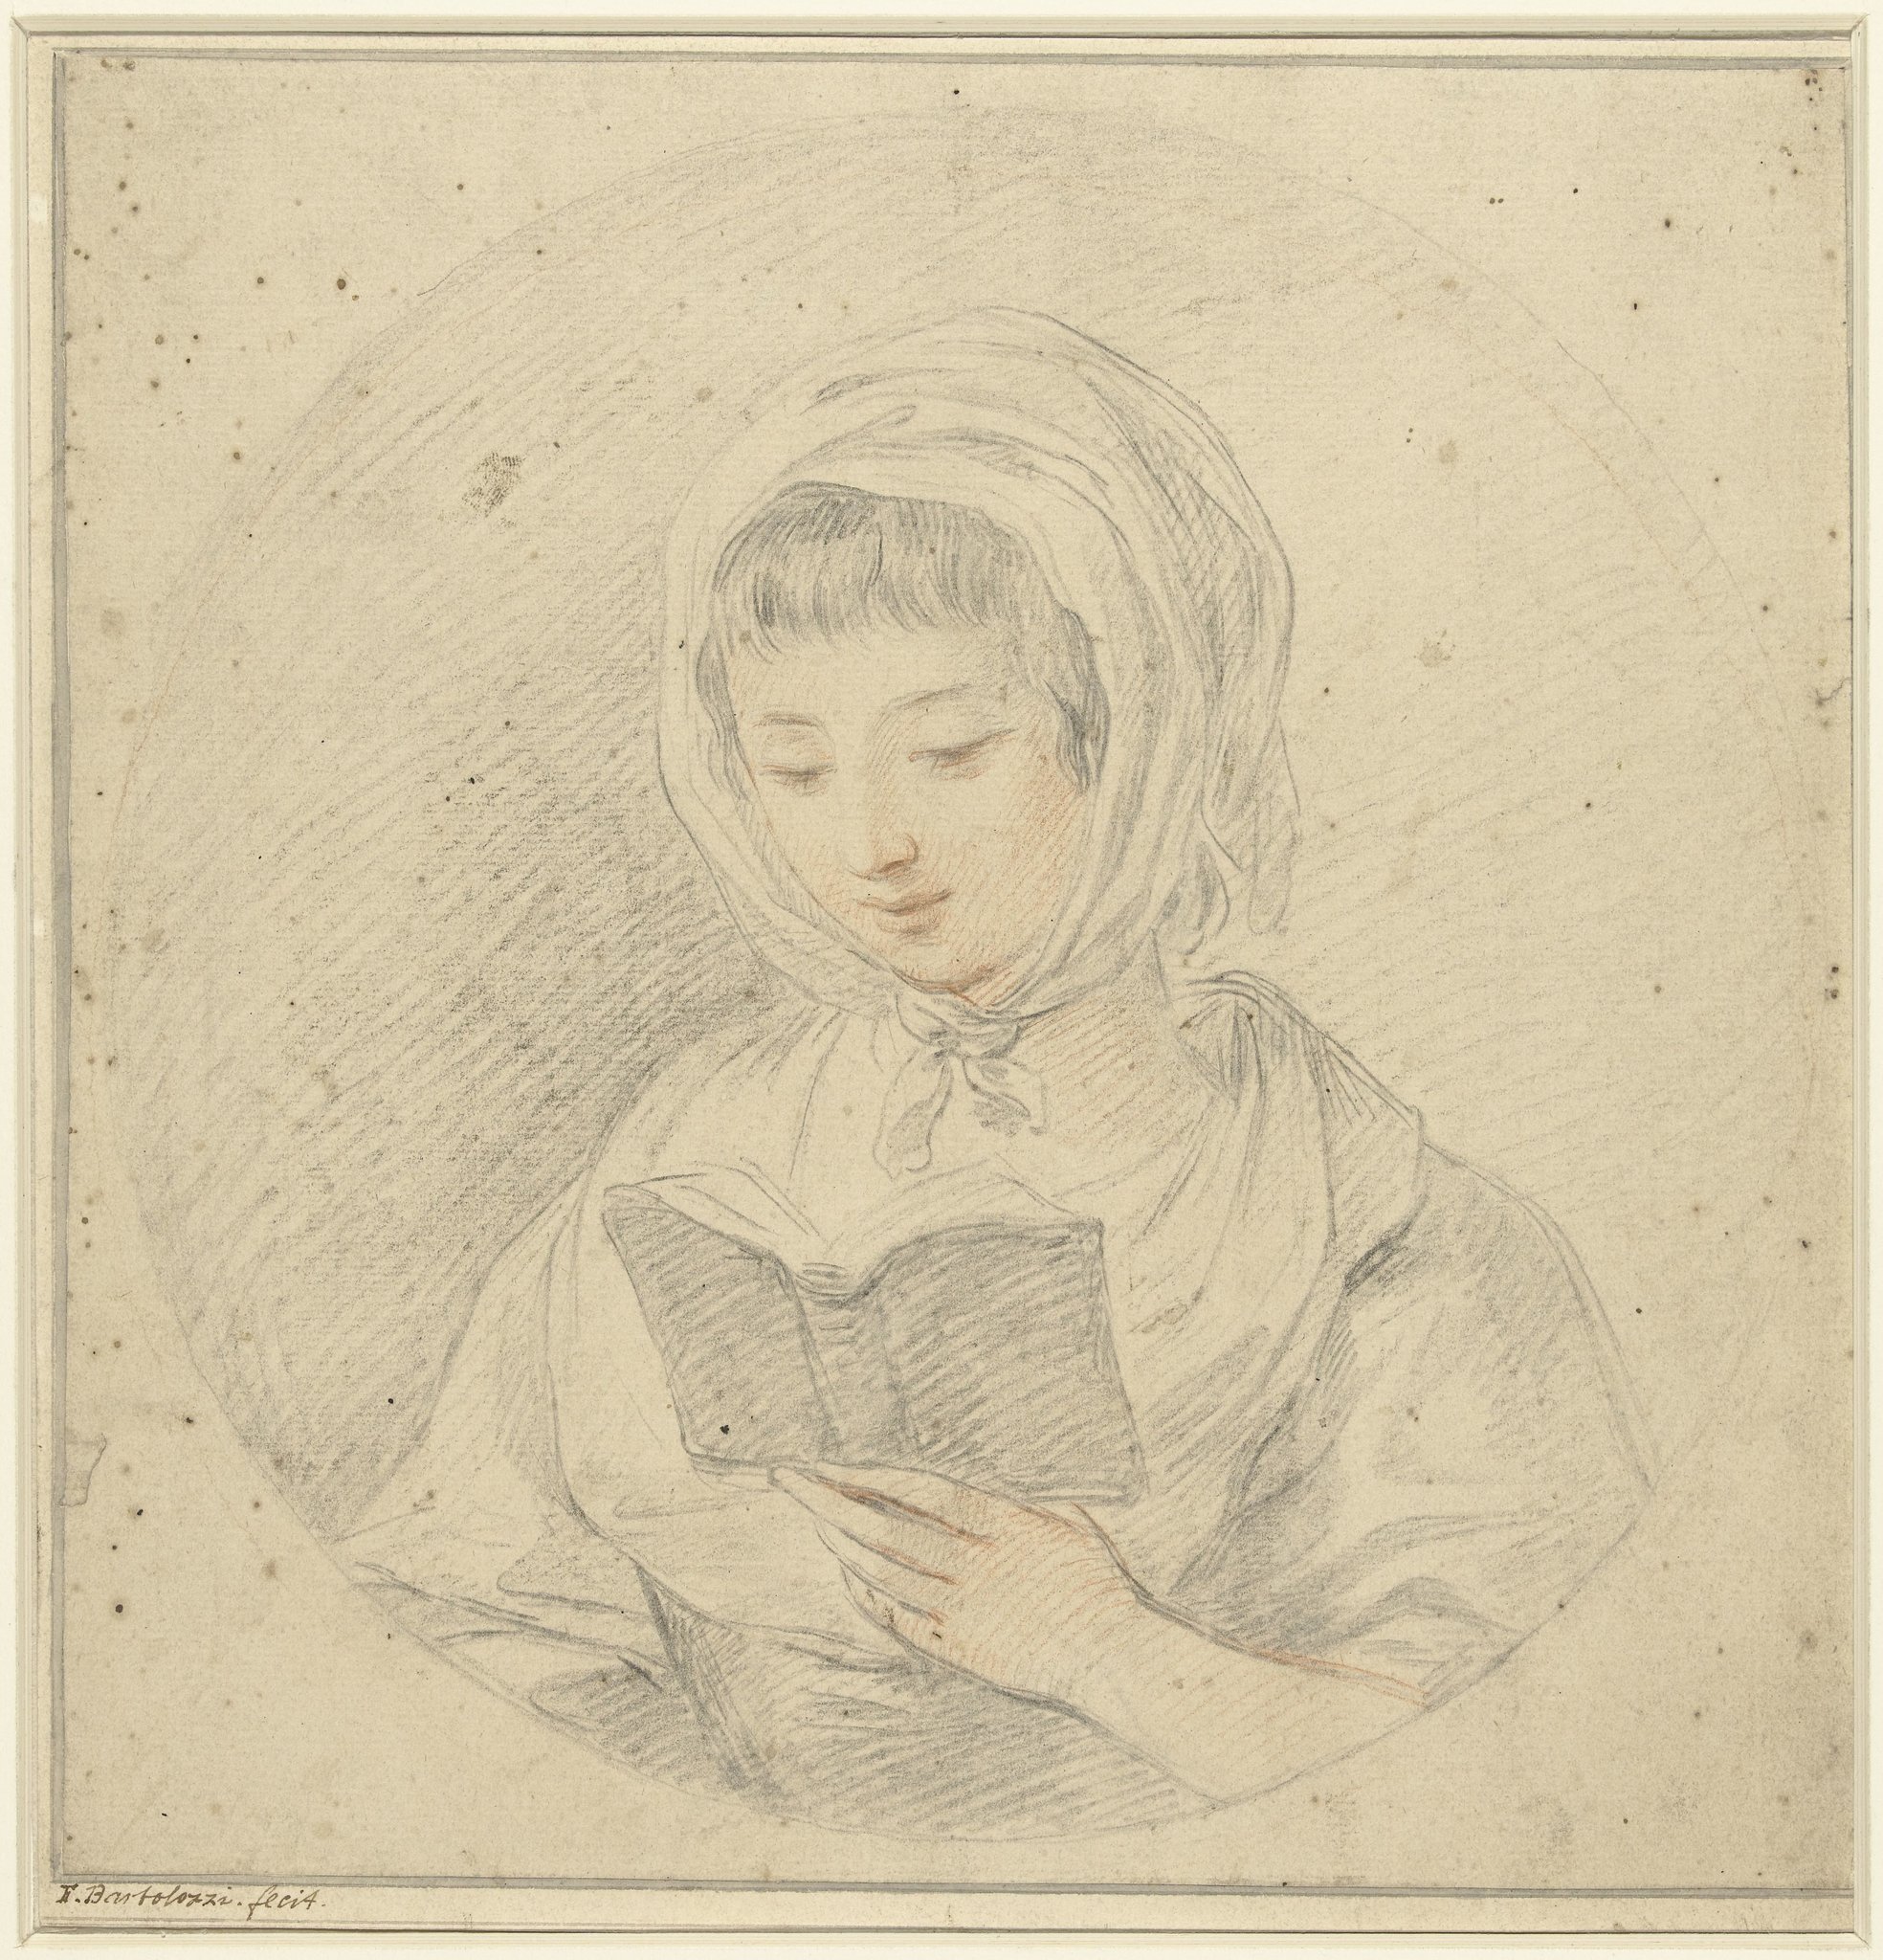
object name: drawing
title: Meisje lezend in een boek, in een ovaal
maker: francesco bartolozzi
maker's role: draughtsman, print maker, publisher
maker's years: 1727-1815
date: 1738-1815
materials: chalk, paper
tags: reading, female sex; woman